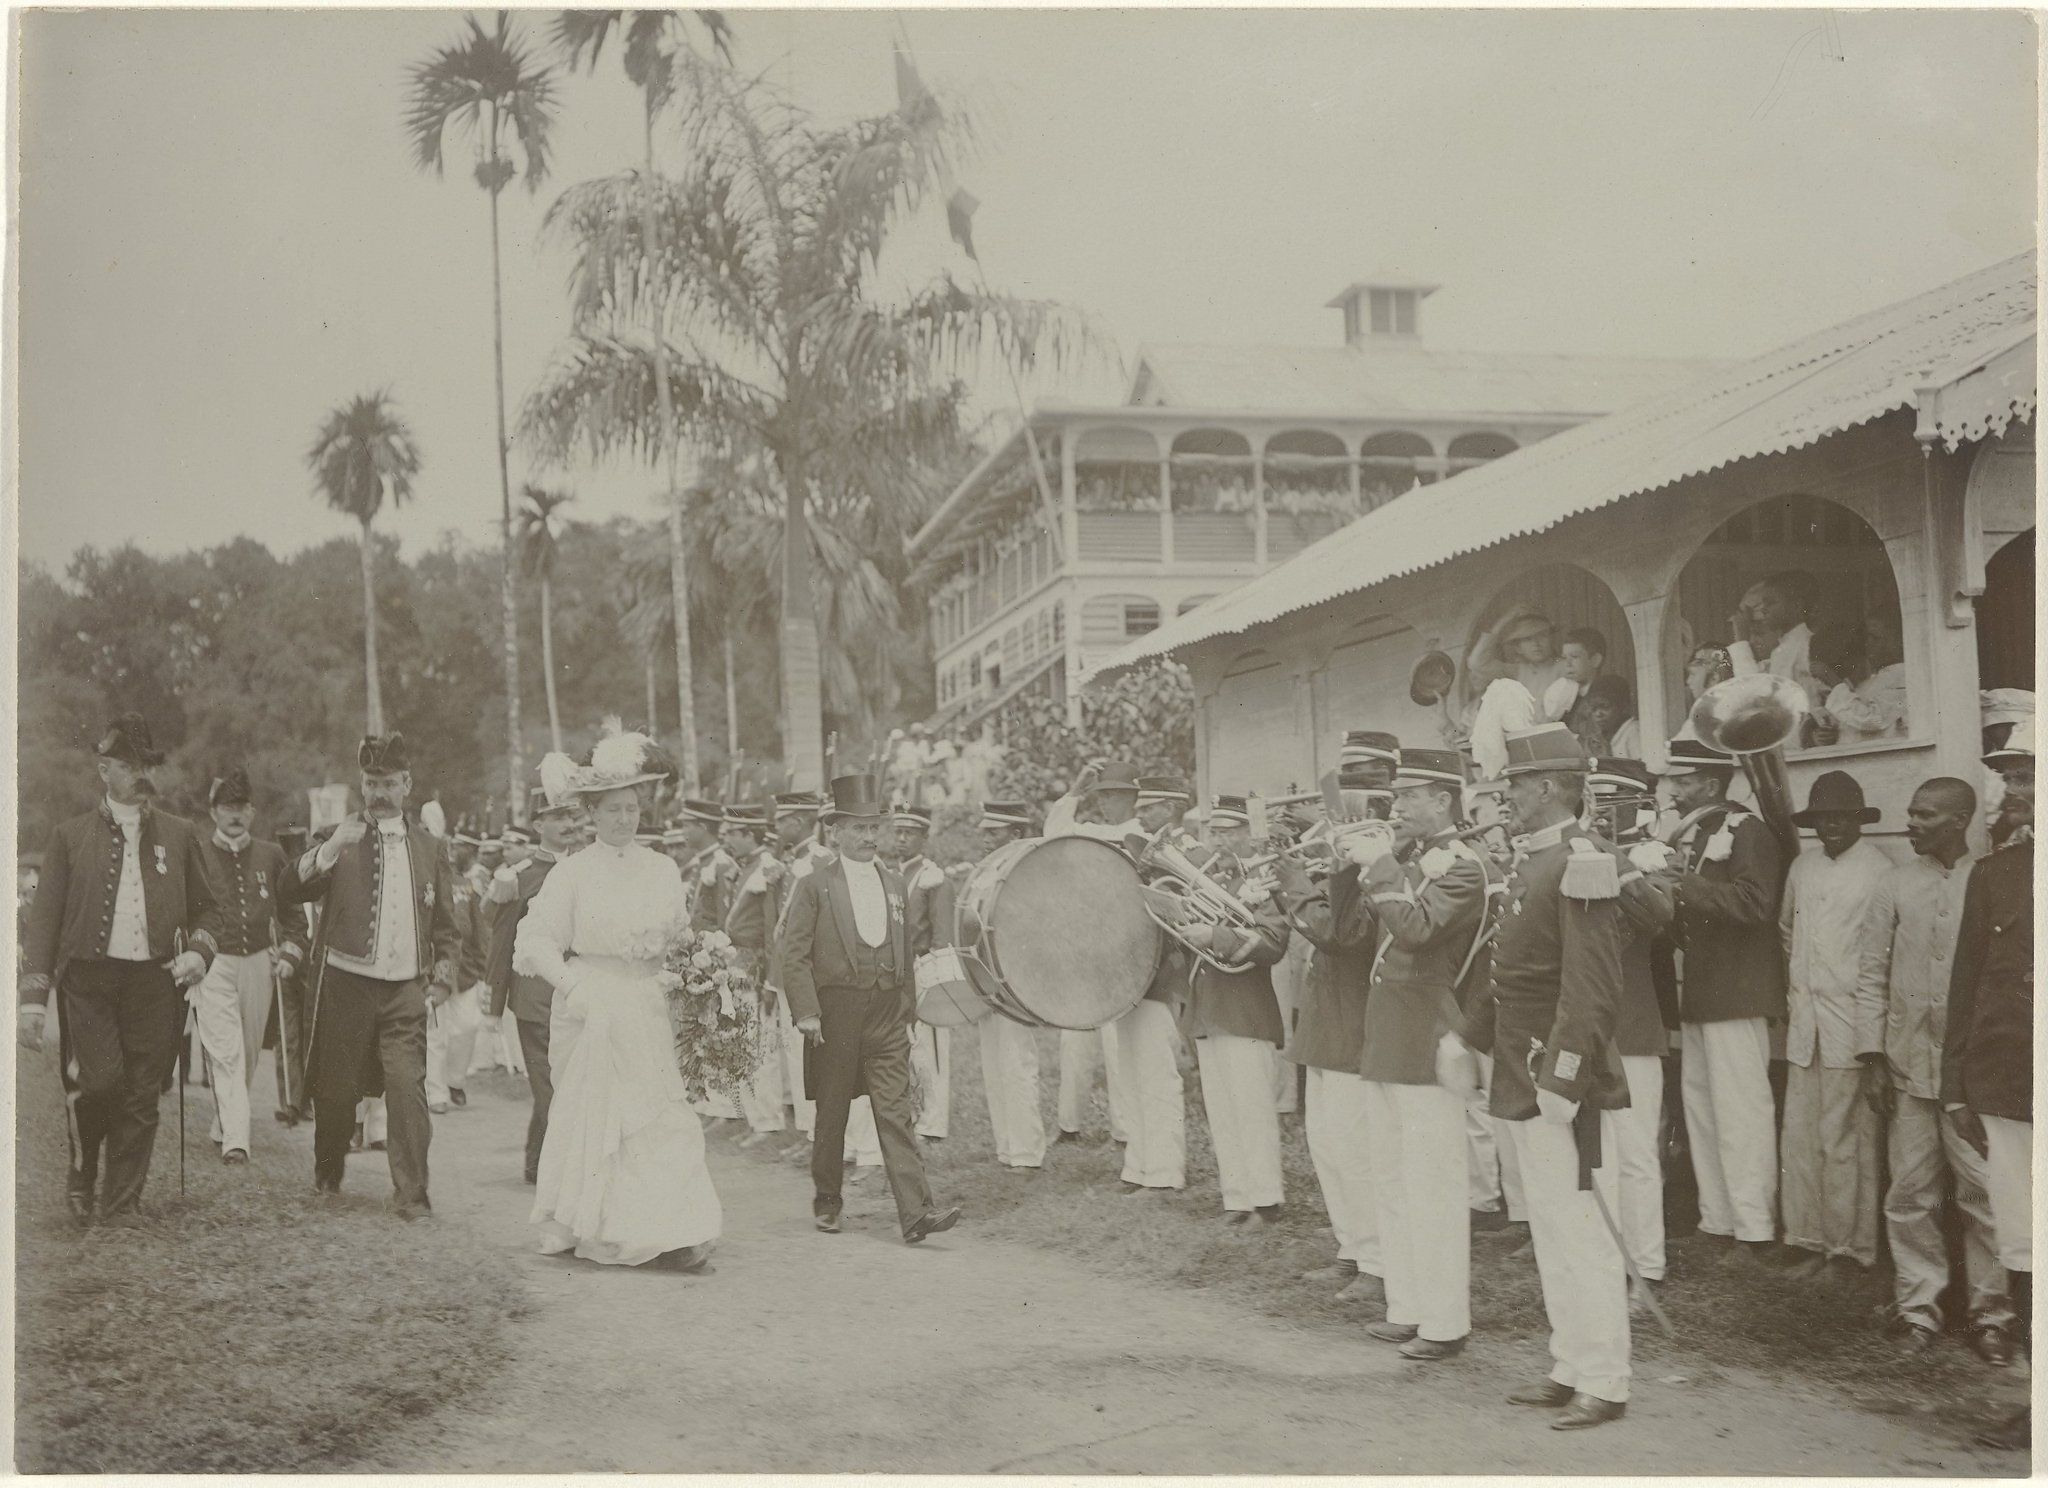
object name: photograph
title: Koninginnedag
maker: Anonymous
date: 1903-1908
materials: photographic support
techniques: photography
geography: paramaribo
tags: meppel, tiel, rechter, jurist, gouverneur, procureur-generaal, advocaat-generaal, petrus hofstede crull, paramaribo (stad), koninginnedag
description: P. Hofstede Crull is met zijn vrouw en diverse andere hoogwaardigheidsbekleders aangekomen bij een groot wit houten huis. Voor het huis speelt een muziekkapel. Crull is op dit moment waarnemend gouverneur van Suriname. Koninginnedag te Paramaribo.